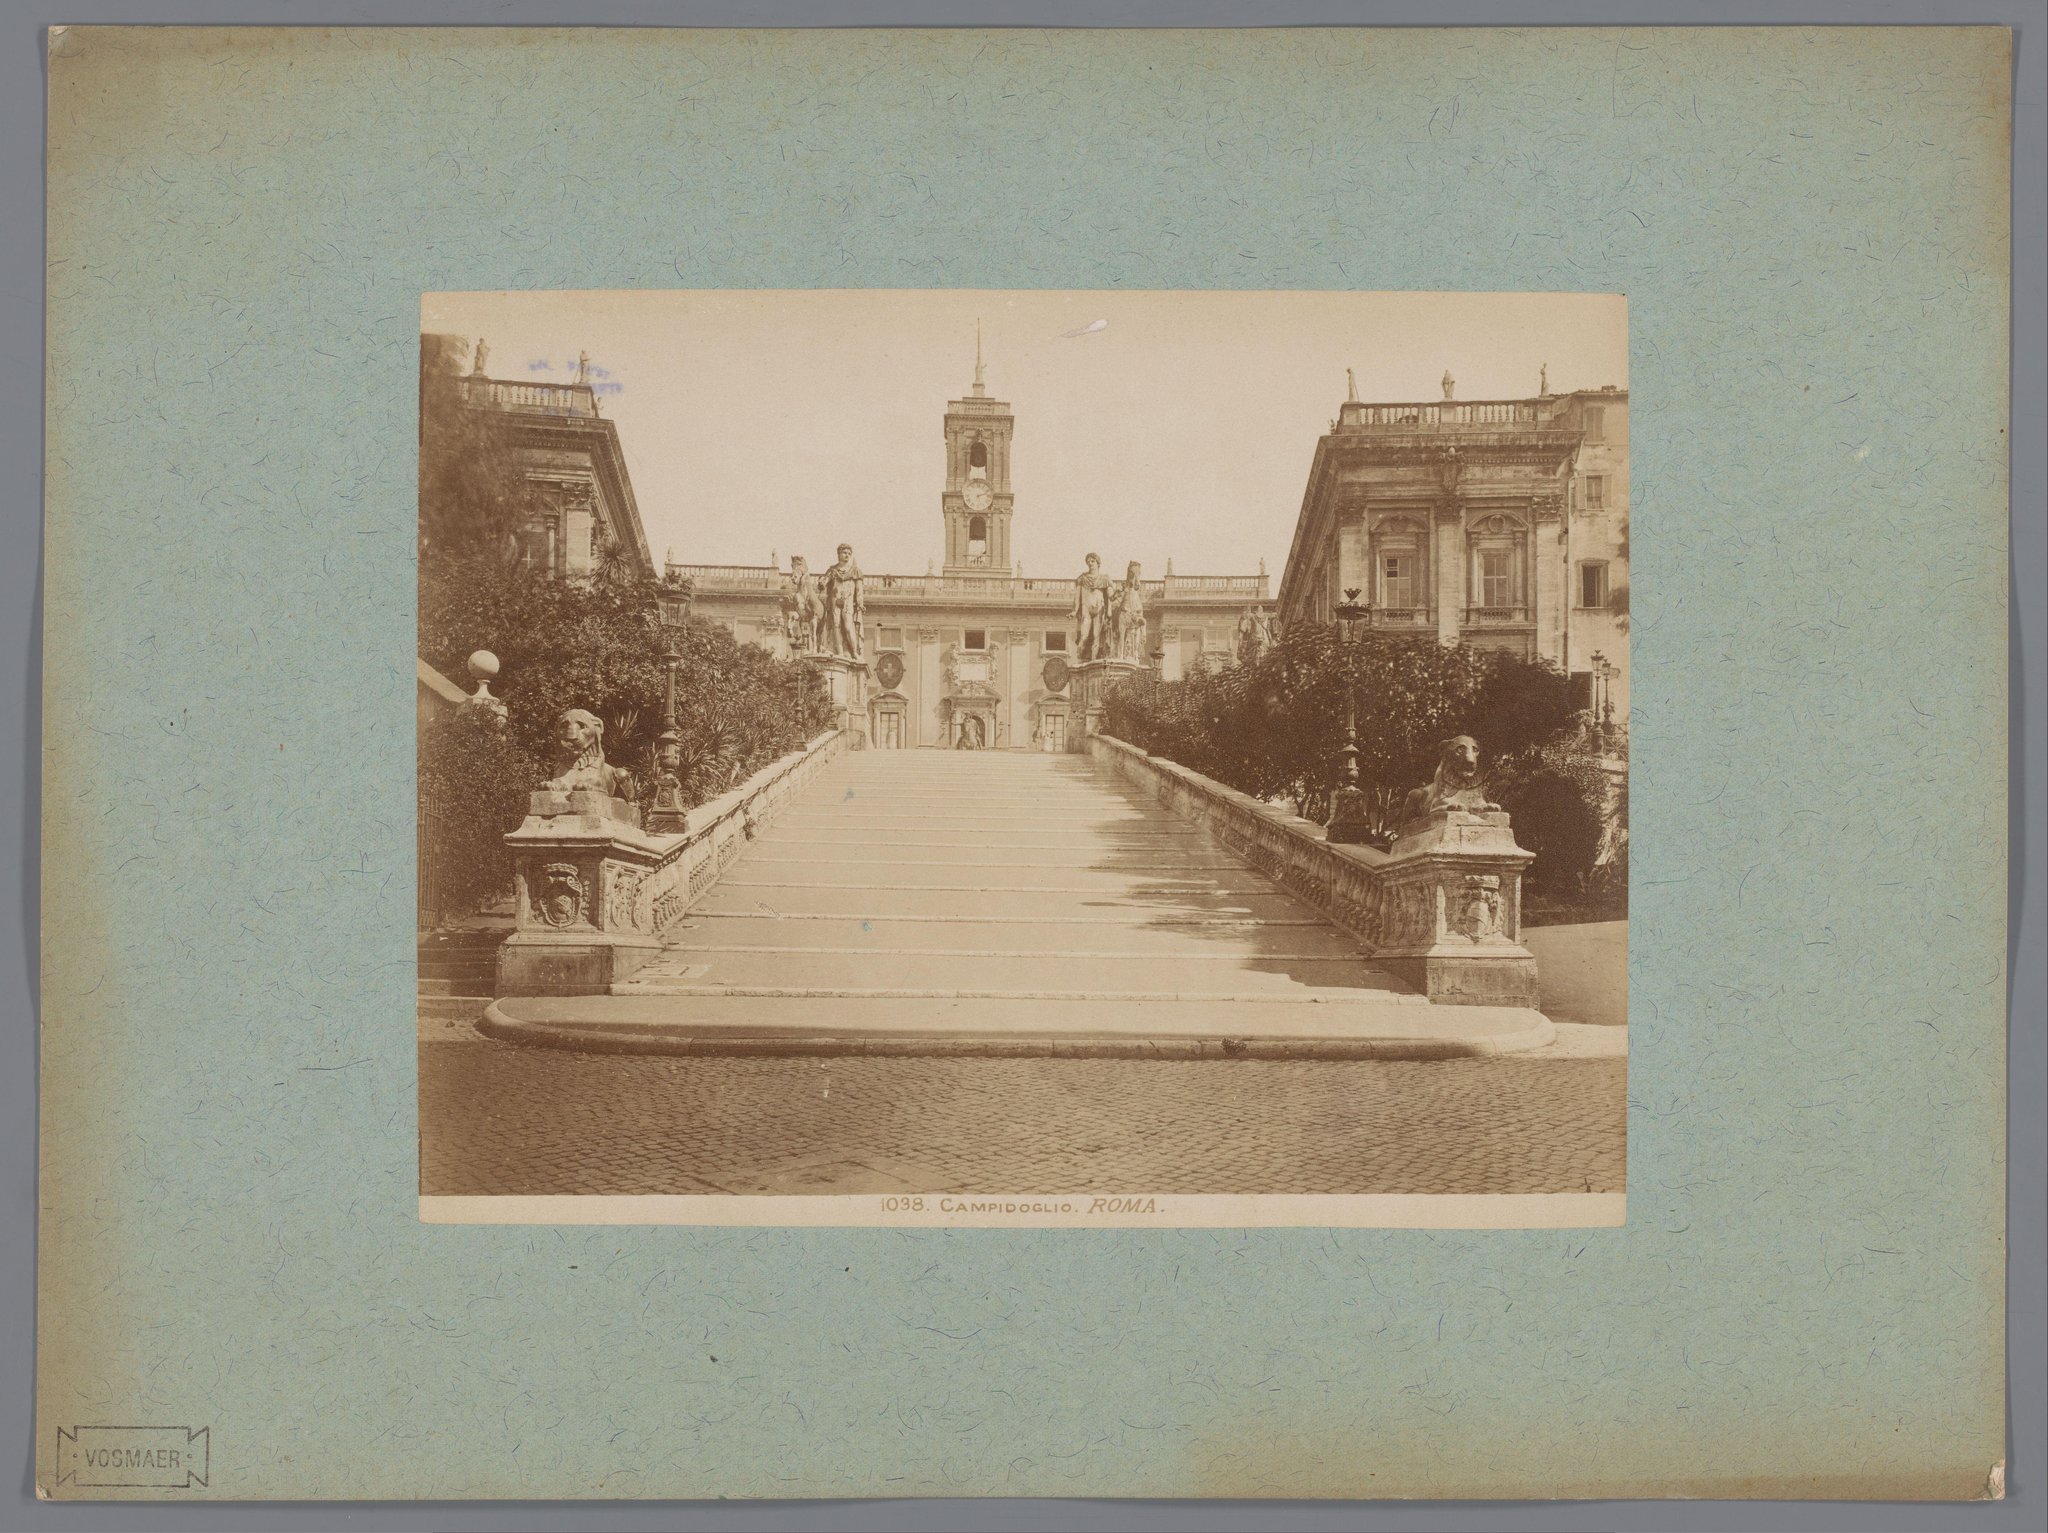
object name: photograph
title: Roma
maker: Anonymous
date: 1851-1900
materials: cardboard, paper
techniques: albumen print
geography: rome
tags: palace, staircase, rome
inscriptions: number: ‘1038.’, collector's mark: ‘VOSMAER’